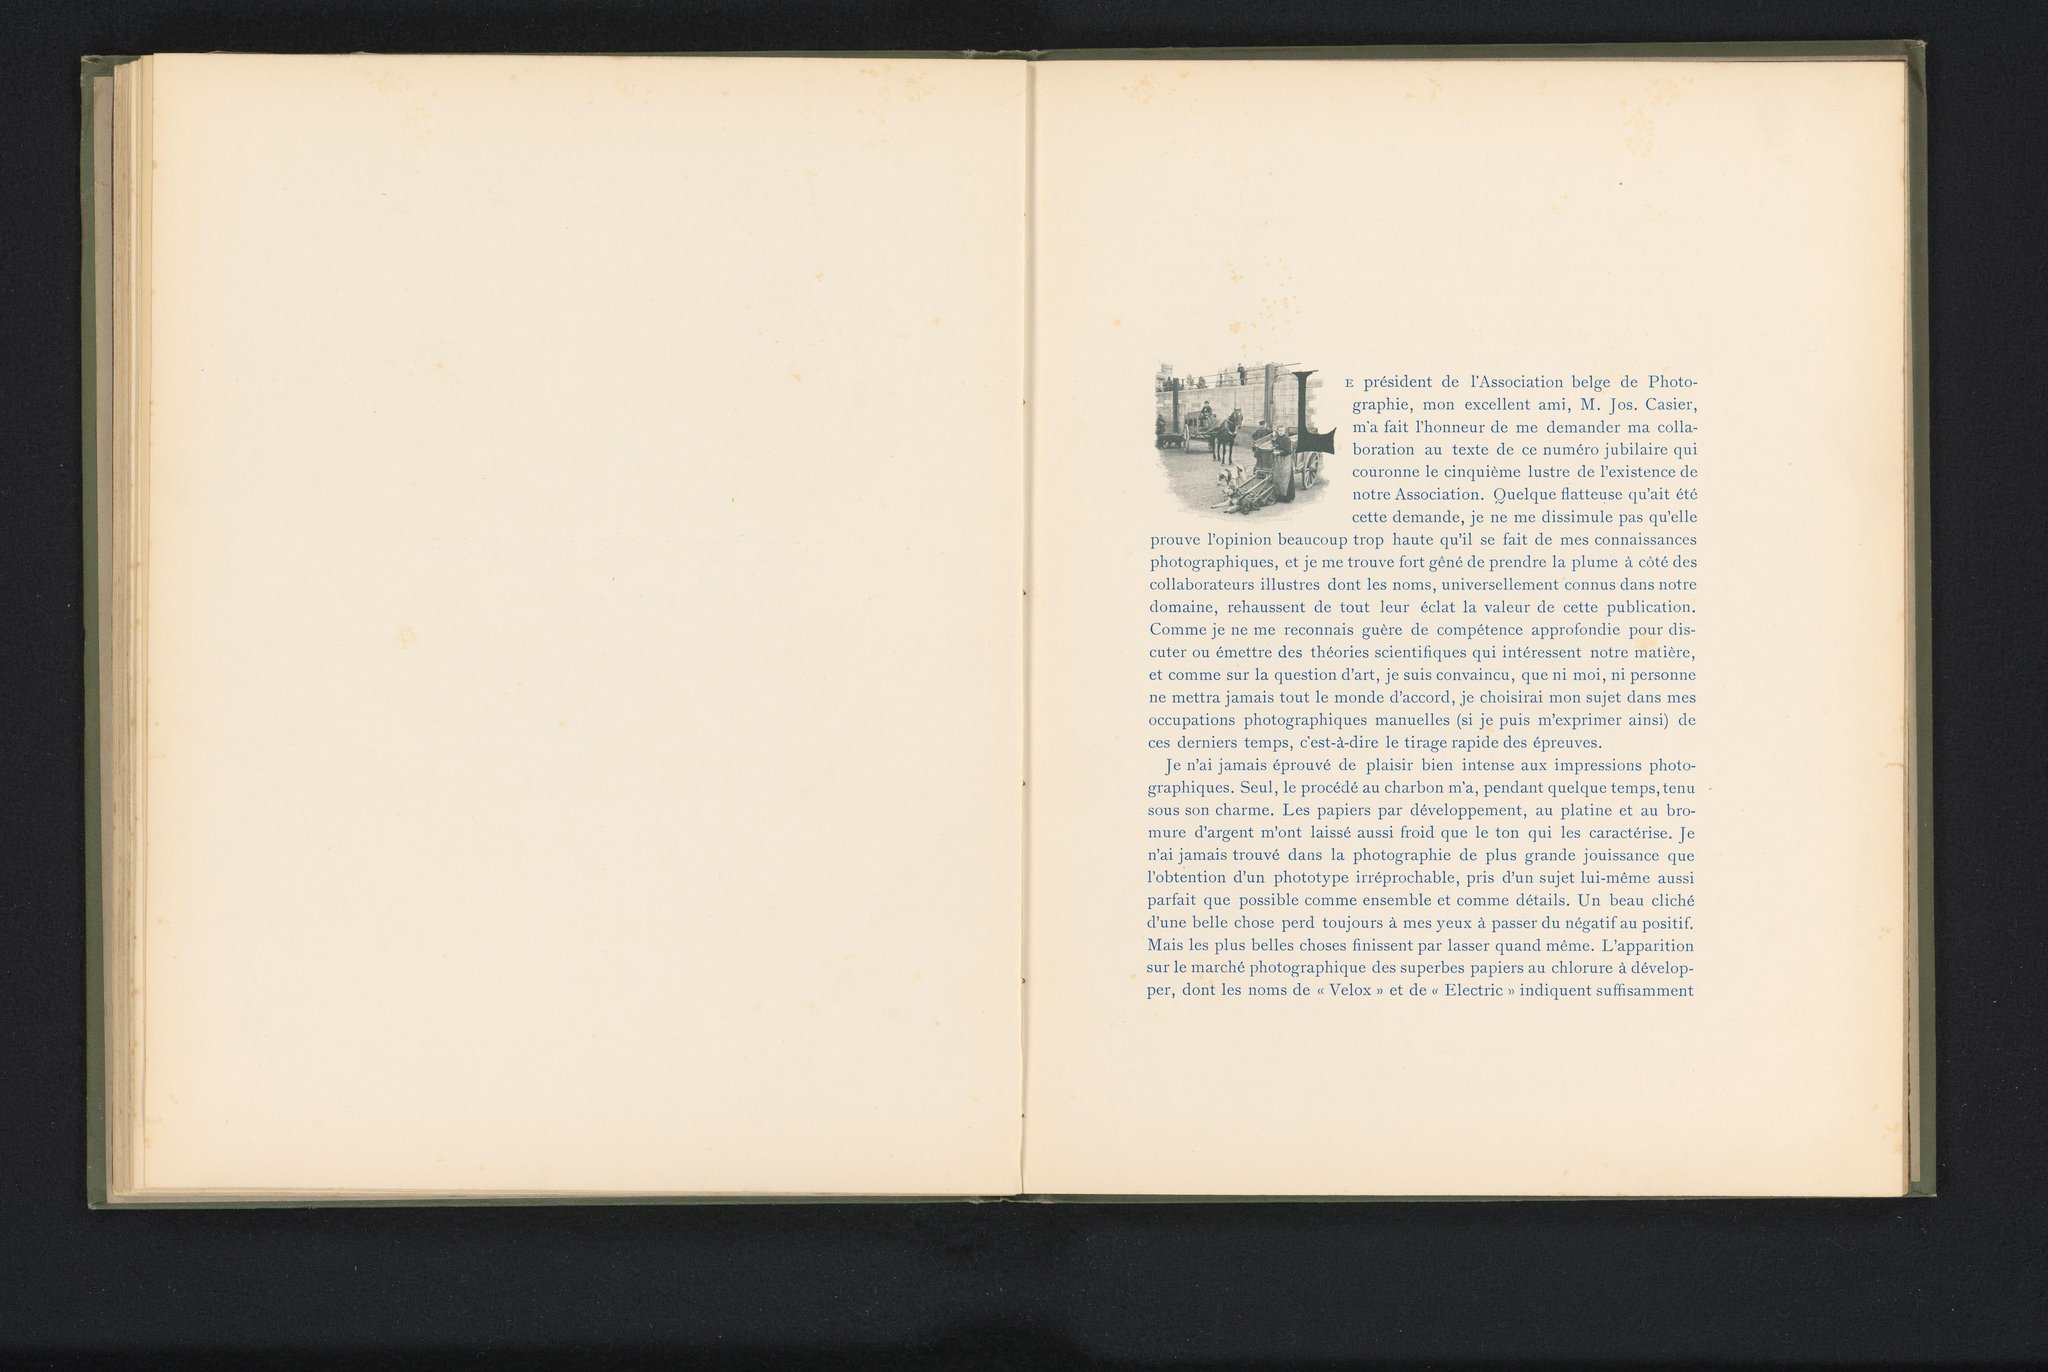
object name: photomechanical print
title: Straatgezicht met hondenkar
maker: Anonymous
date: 1893-1898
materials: paper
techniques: autotype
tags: four-wheeled vehicle drawn by two animals, dog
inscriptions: inscription: ‘Electric paper.’, inscription: ‘Association Belge de photographie’